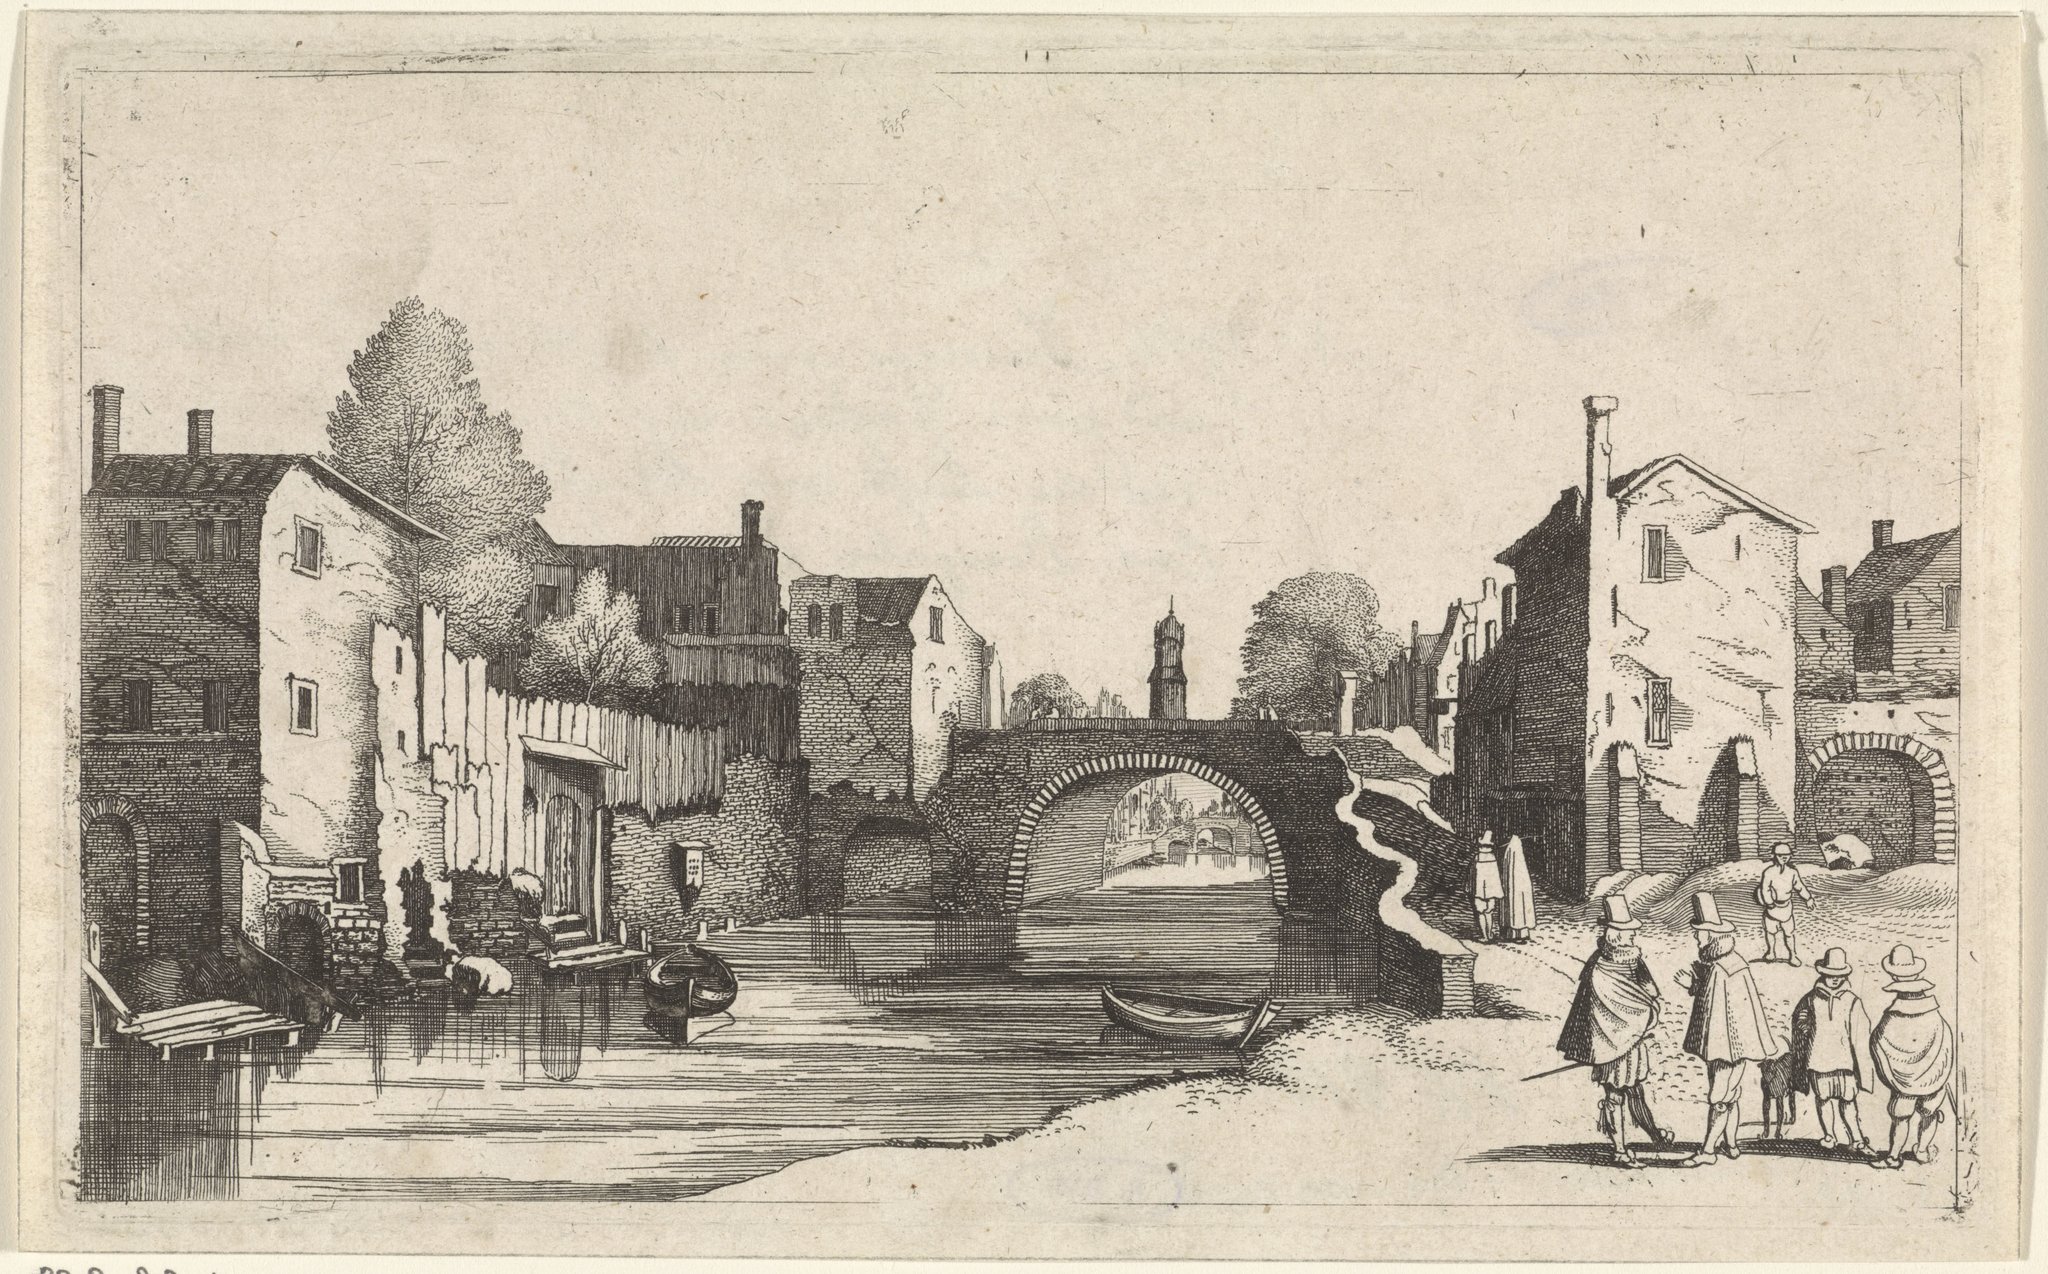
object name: print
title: Gezicht op een kanaal in een stad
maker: jan van de velde (ii)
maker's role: draughtsman, painter, print maker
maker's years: 1593-1641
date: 1603-1641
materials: paper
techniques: etching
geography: northern netherlands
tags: canals, waters (in village), canals, waters (in city), bridge in city across river, canal, etc., parts of church exterior and annexes: tower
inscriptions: collector's mark: Lugt 2228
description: Een stadgezicht met een brug over een kanaal. Rechts twee converserende heren en twee jongens met een hond. Prent uit een serie van acht met marines.